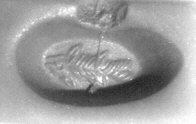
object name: stamp seal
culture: sasanian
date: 201-700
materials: stone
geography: iran or mesopotamia